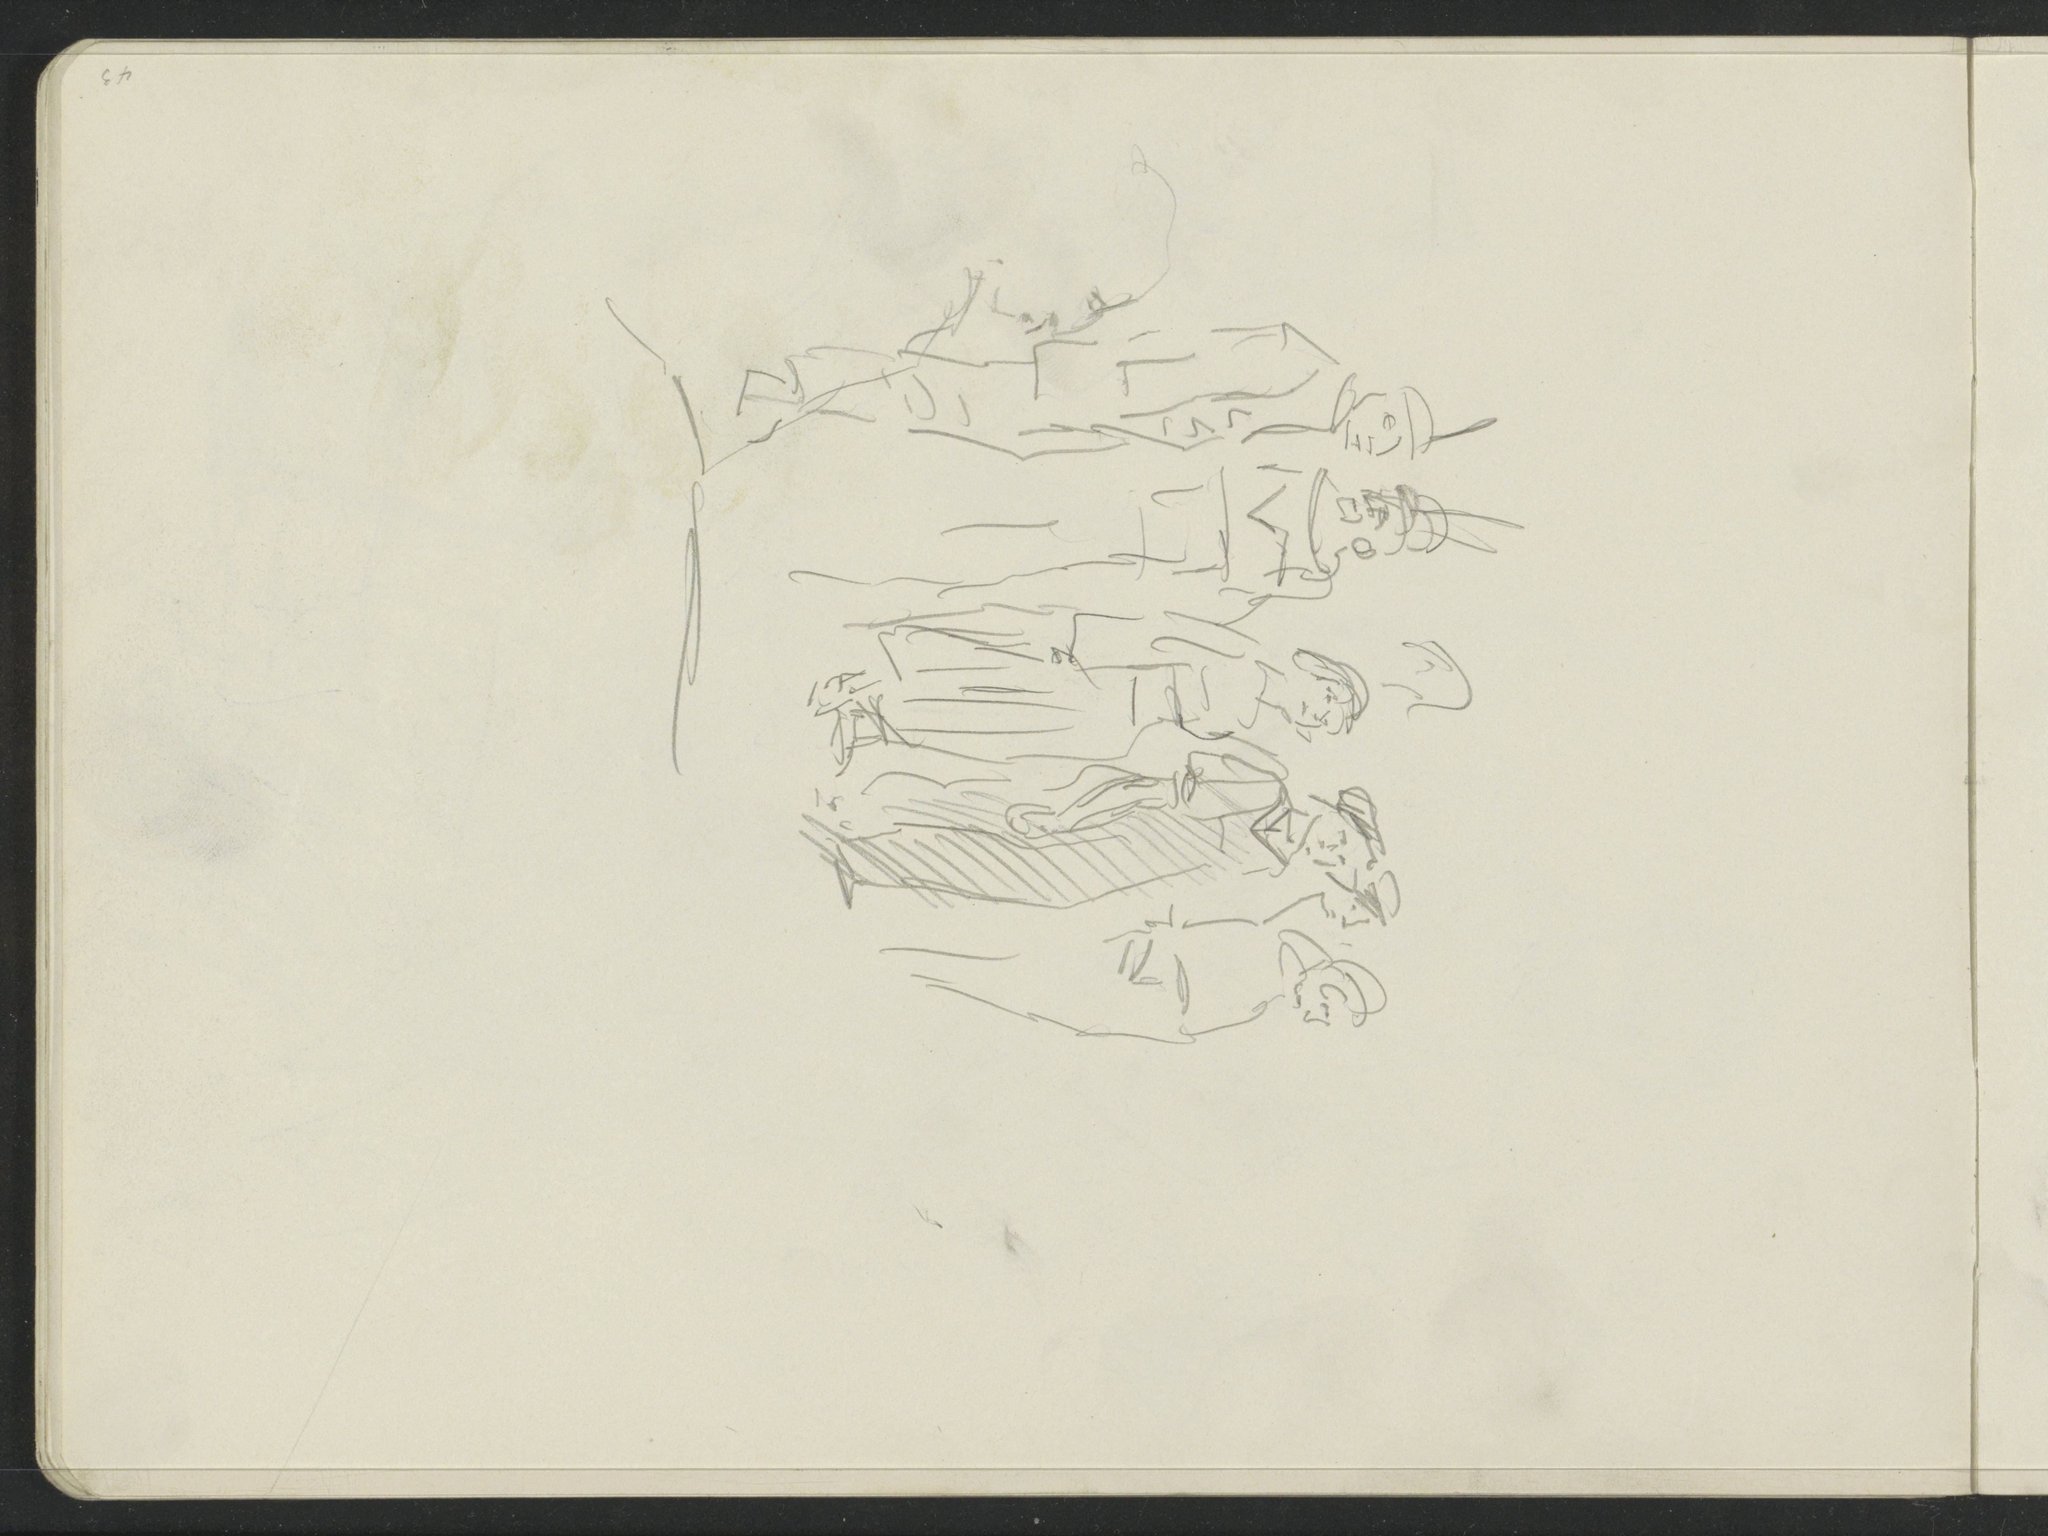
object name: sketchbook leaf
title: Groep figuren, mogelijk verkleed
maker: isaac israels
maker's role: draughtsman, painter, print maker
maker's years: 1865-1934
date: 1915-1934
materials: paper, pencil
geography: the hague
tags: adult woman, stage costume, adult man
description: Blad 20 verso uit schetsboek XVII met 31 bladen.